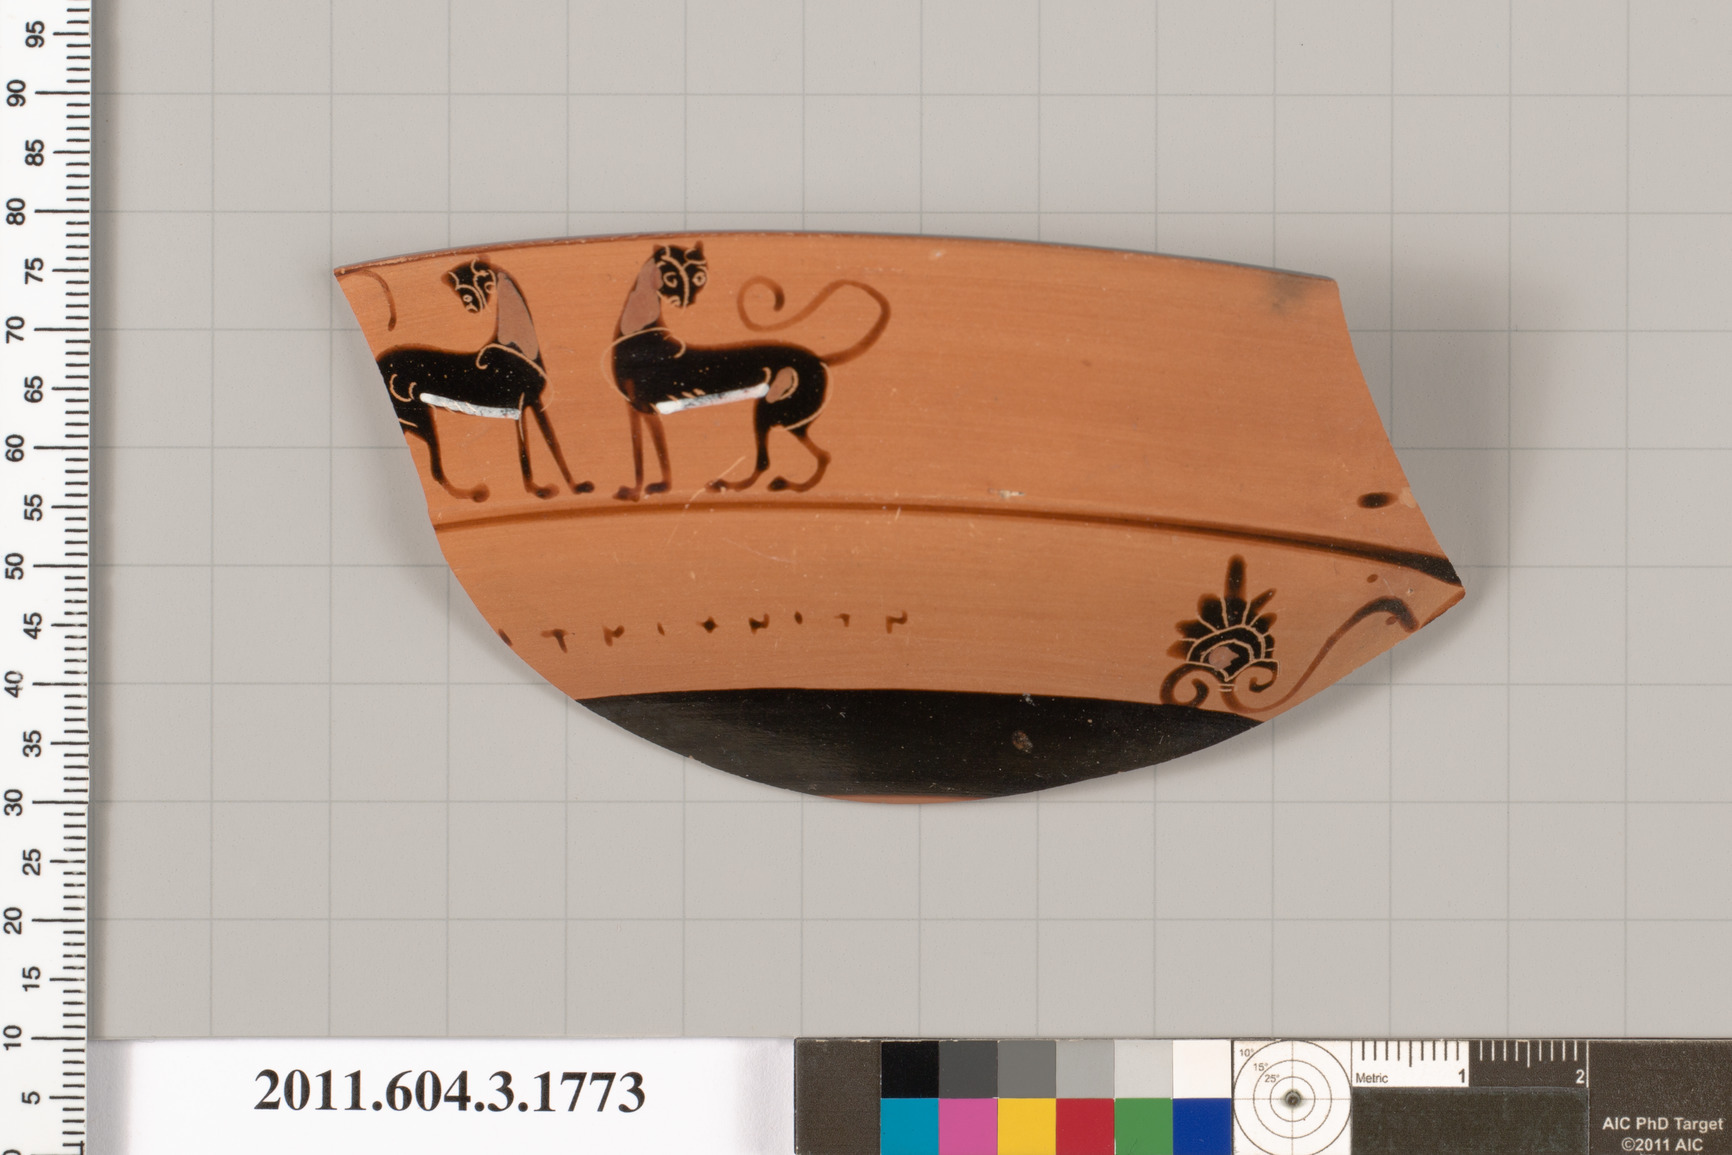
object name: kylix fragment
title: Terracotta rim fragment of a kylix: Lip cup (drinking cup)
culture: greek, attic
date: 560-550 BCE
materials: terracotta